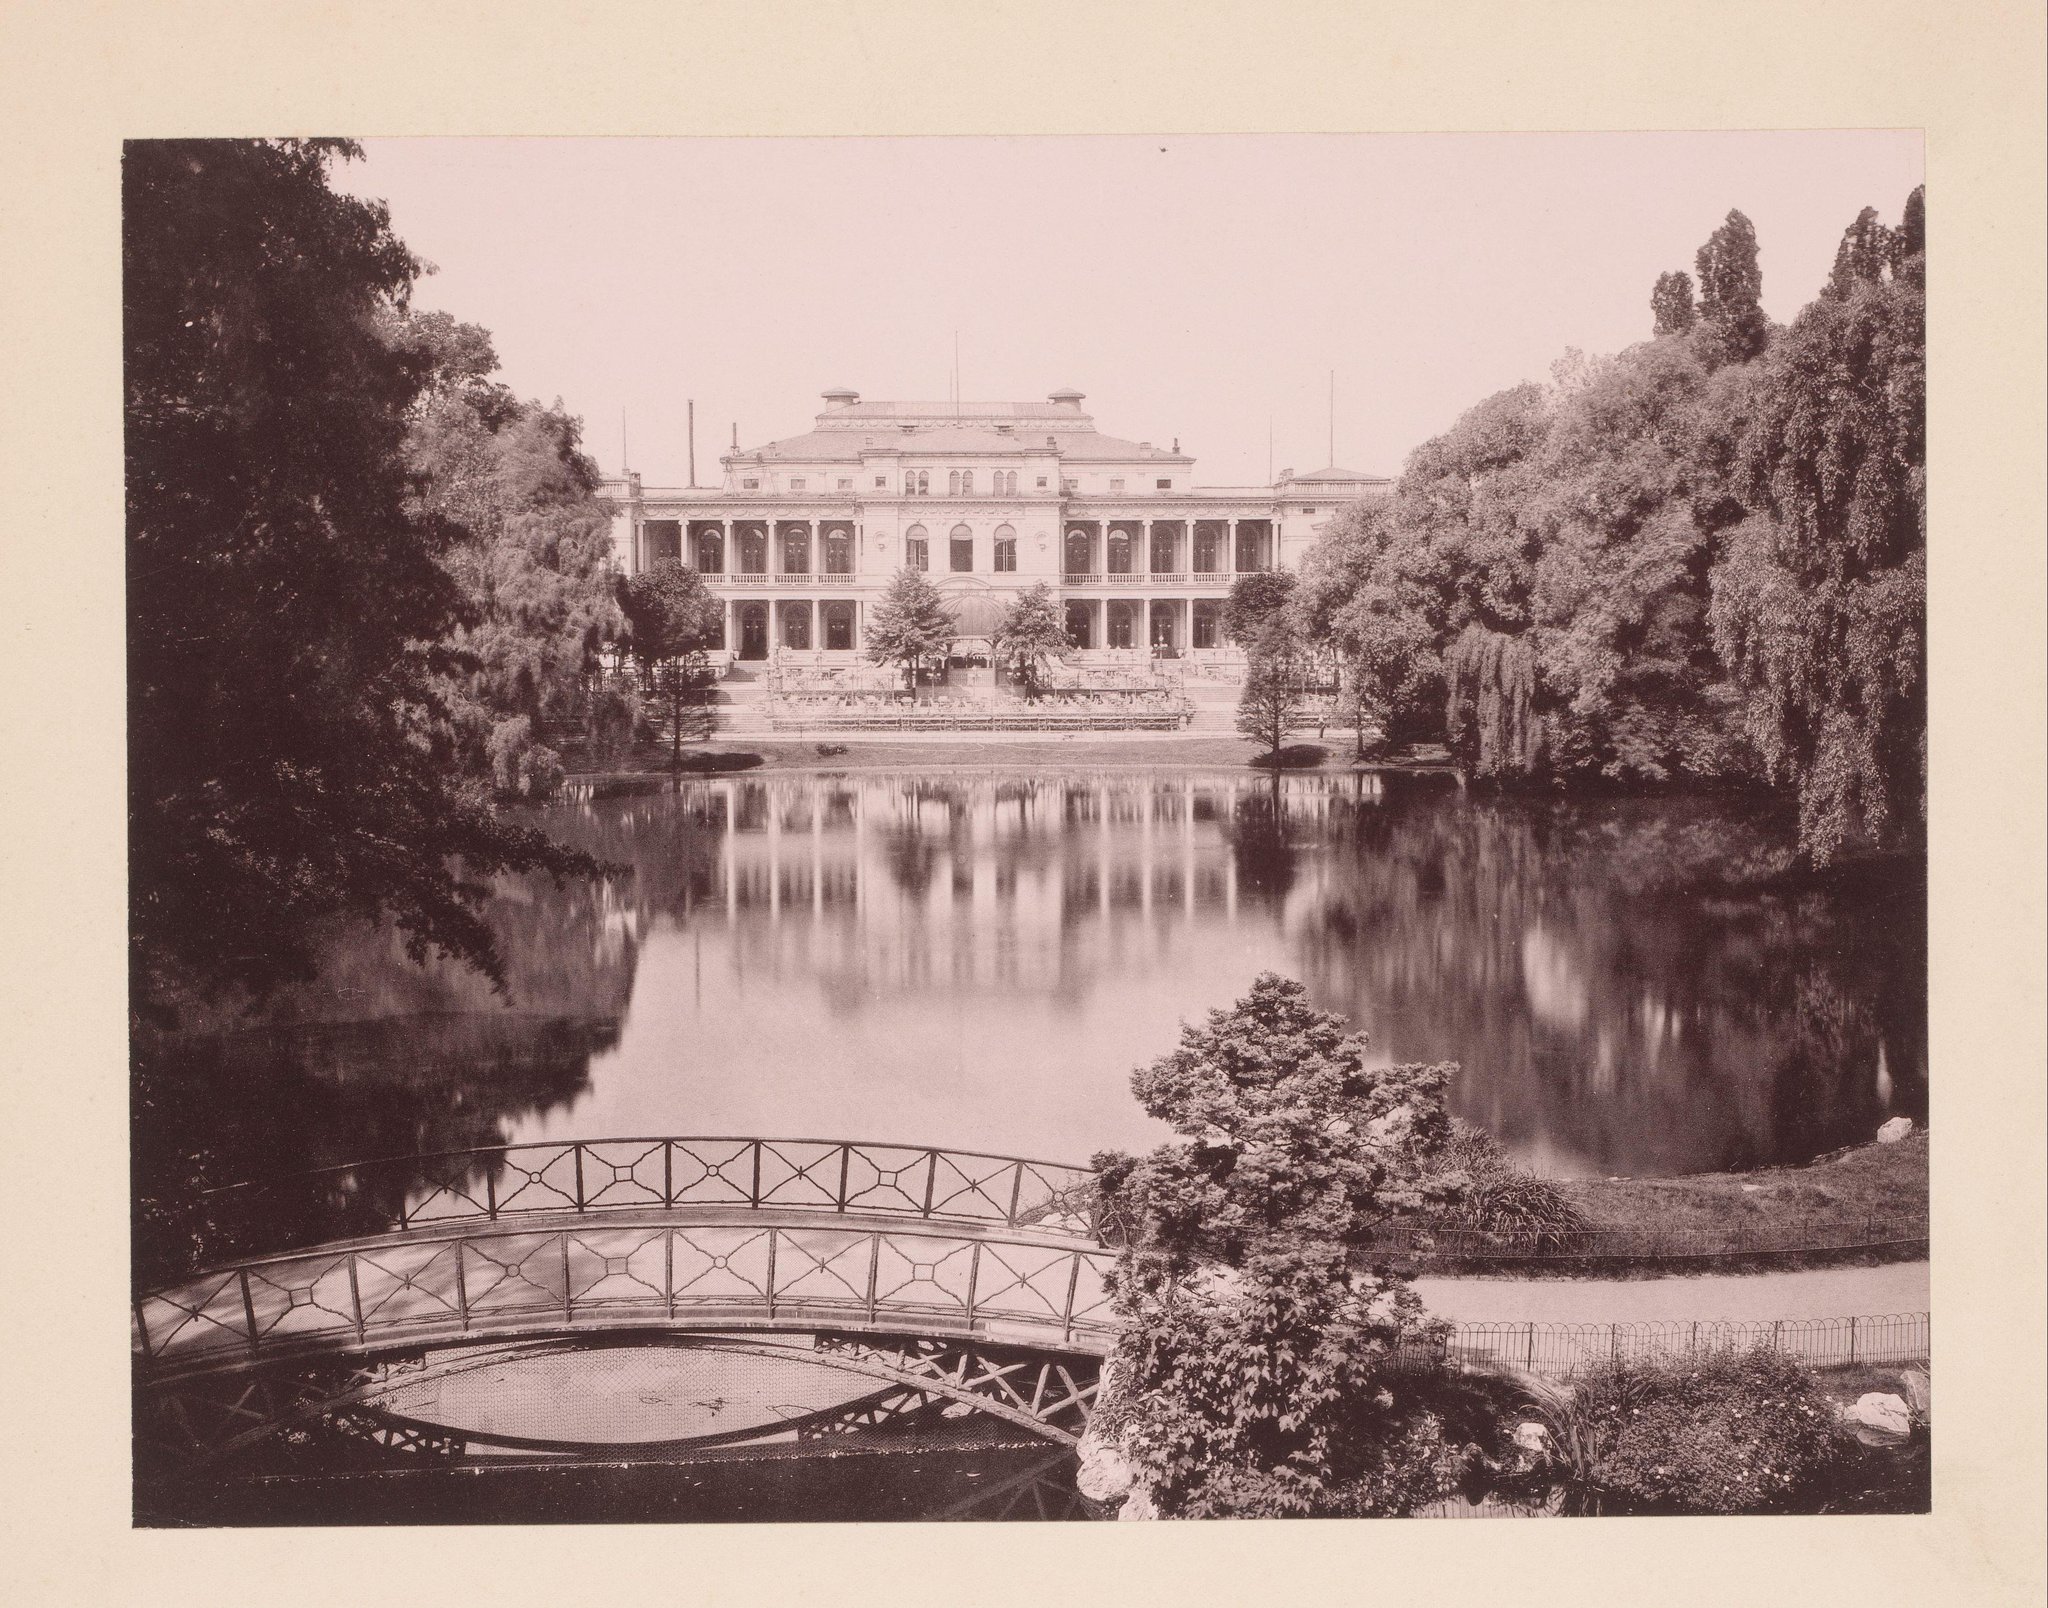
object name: photograph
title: Huis in een park aan een grote vijver, Frankfurt am Main [?], Duitsland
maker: Anonymous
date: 1885-1895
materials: cardboard, paper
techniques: albumen print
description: Huis in een park aan een grote vijver, Frankfurt am Main [?], Duitsland.